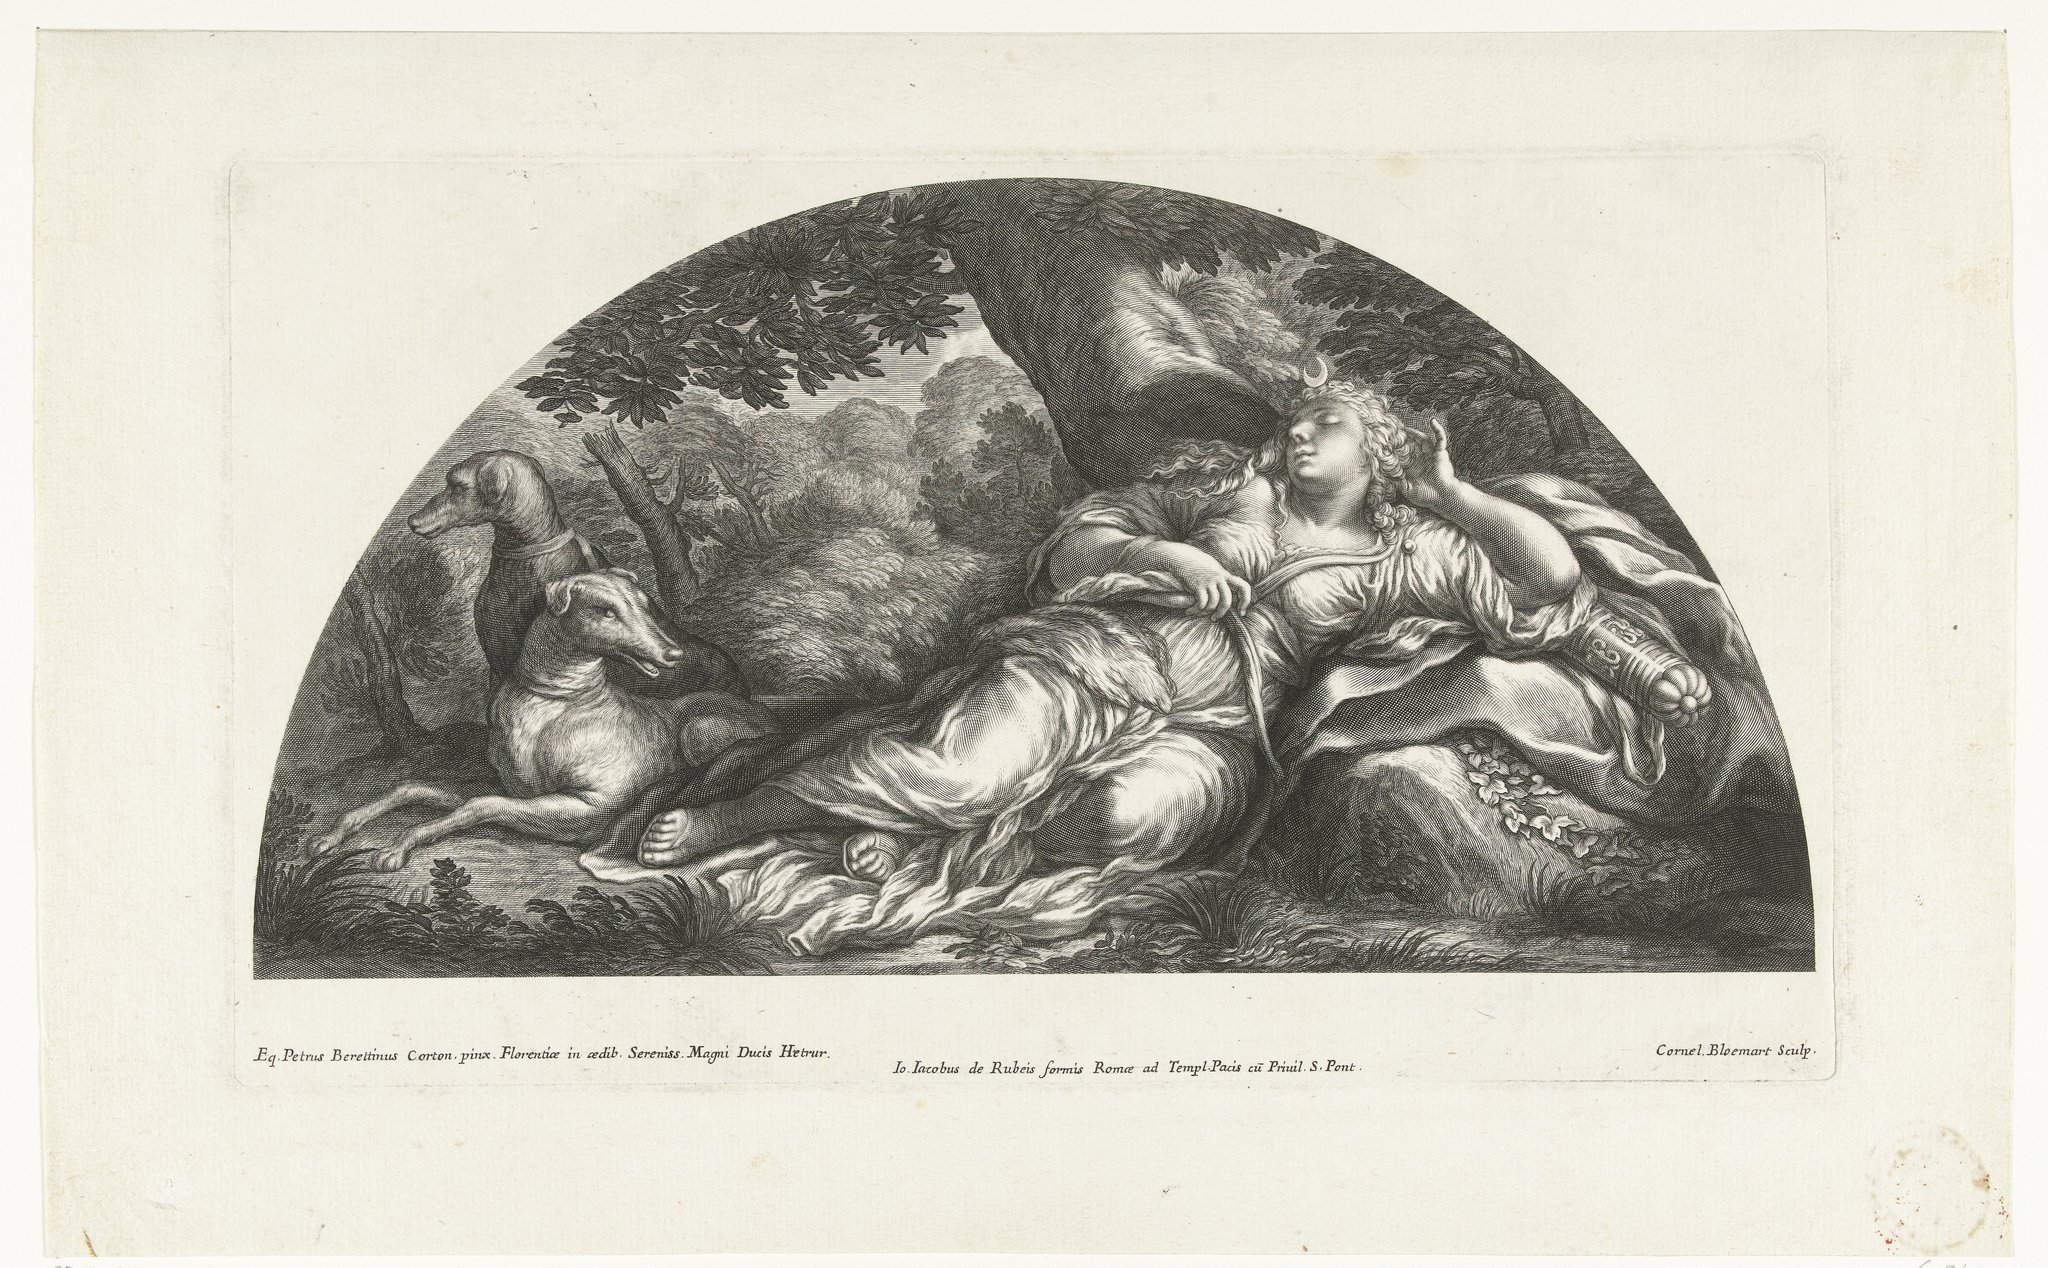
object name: print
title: Diana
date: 1637-1692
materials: paper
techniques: engraving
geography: rome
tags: specific aspects, allegorical aspects of diana; diana as patroness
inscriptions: collector's mark: Lugt 240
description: Diana, godin van de aarde en van de jacht, beschermster van het wild, ligt te slapen in het bos. Naast haar twee honden. Haar linkerarm steunt op een pijlkoker. De sikkel van de maan op haar voorhoofd is haar attribuut als maangodin. Prent uit een serie van vier prenten naar fresco's van Pietro da Cortona.